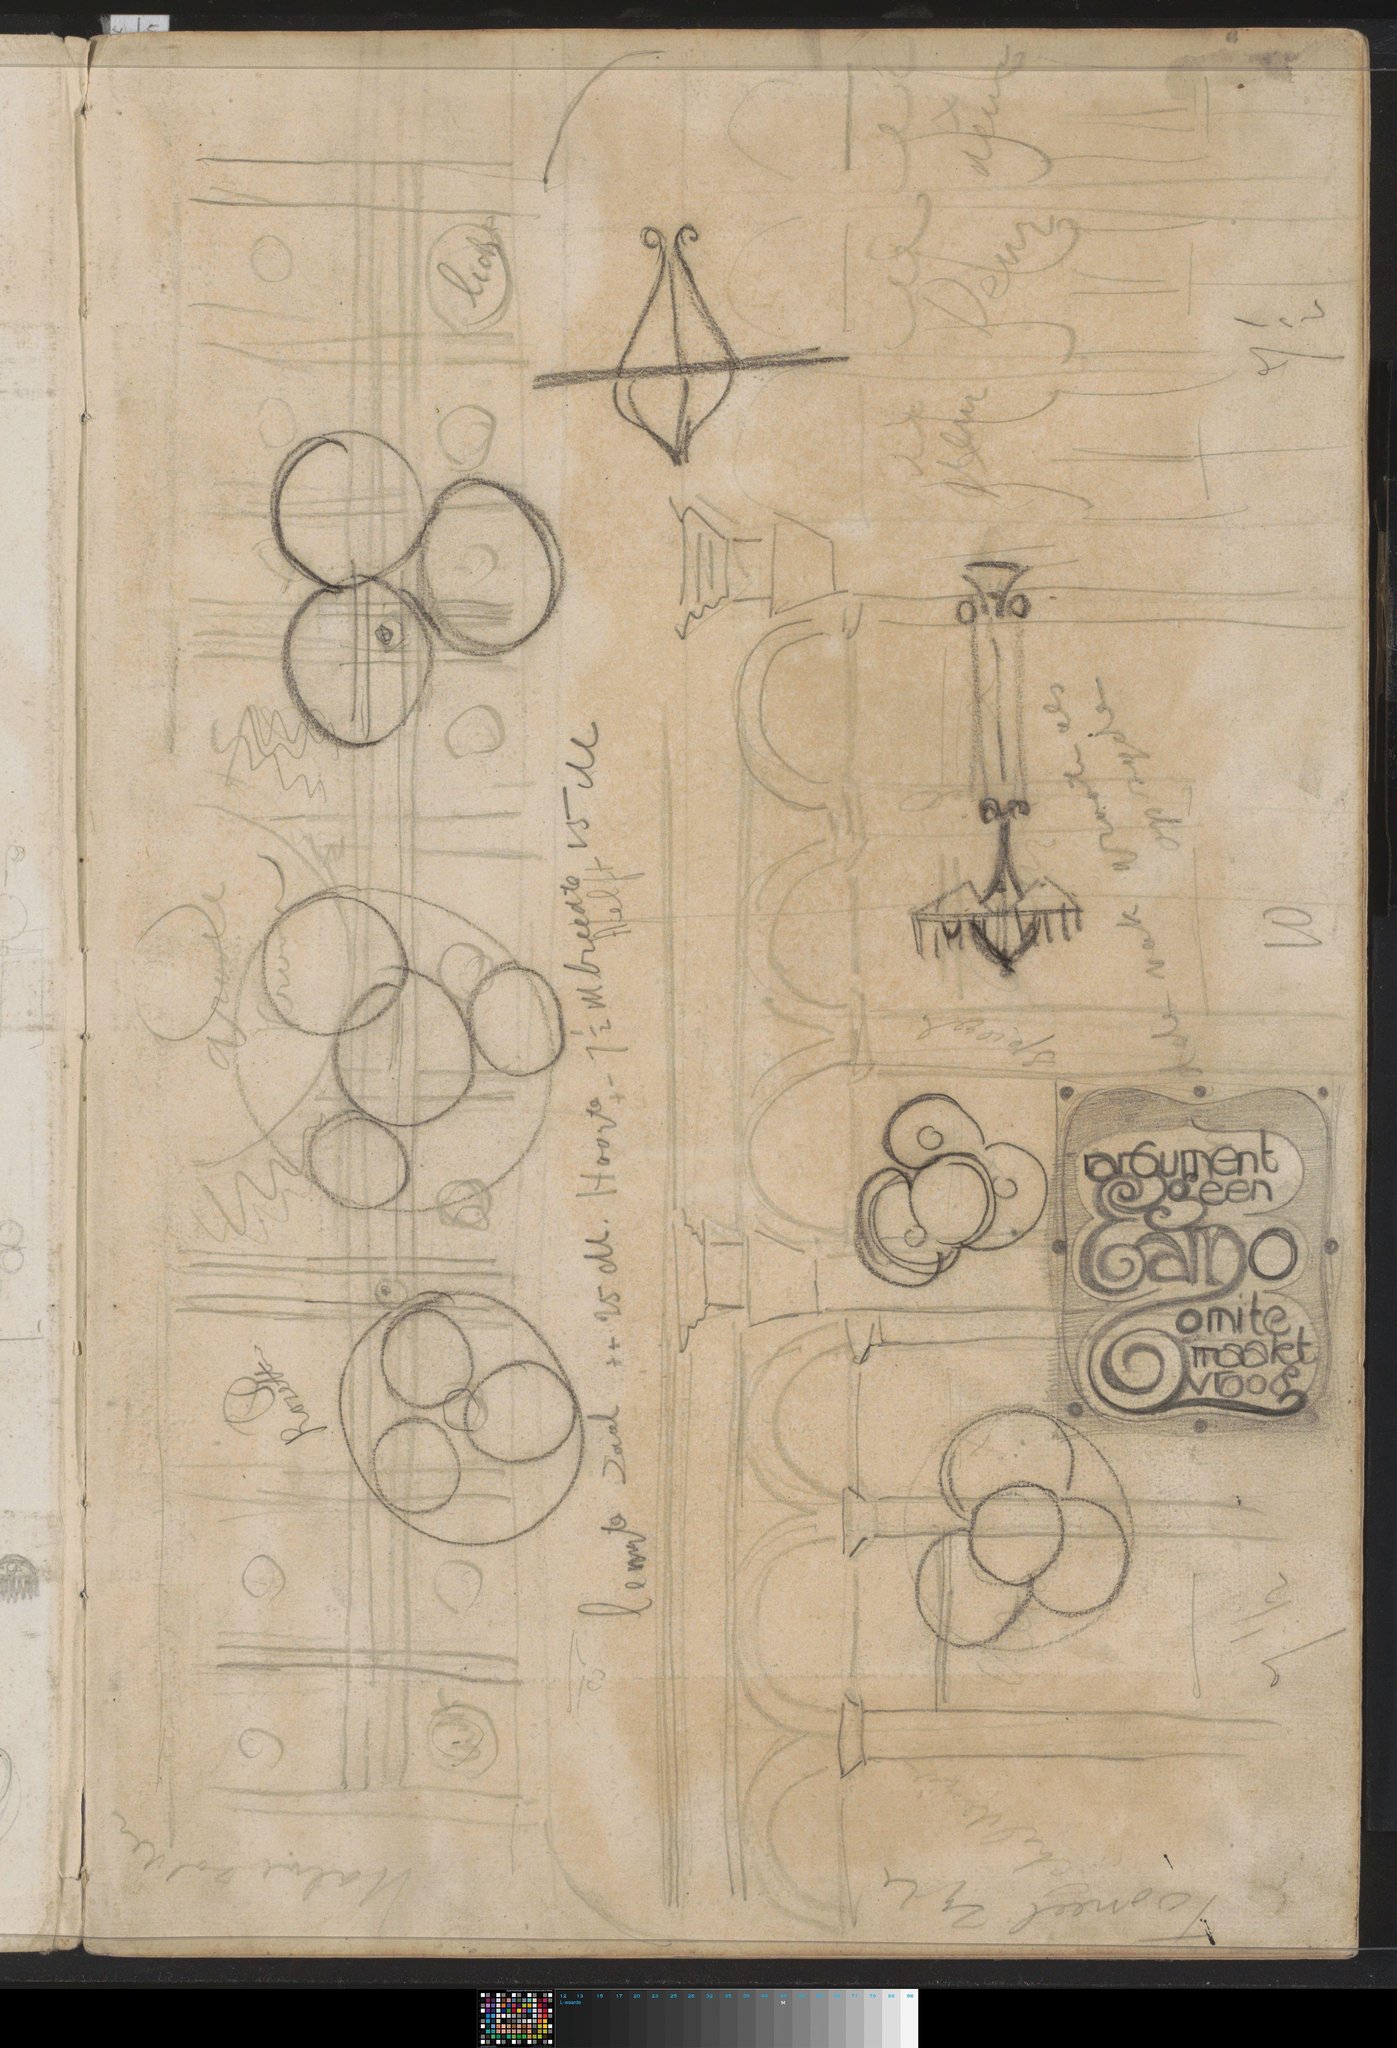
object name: sketchbook leaf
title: Rozetten en een kandelaar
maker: carel adolph lion cachet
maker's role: draughtsman, print maker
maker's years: 1864-1945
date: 1903-1904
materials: chalk, paper, pencil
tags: rosette ~ ornament, chandelier, candelabrum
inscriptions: annotation: ‘Tooneel [...] halve [...] Rozetten/ lengte zaal ++ 25 dl Hoogte +- 7 1/2 M breedte/ Helft 15 [...]/ spiegel/ [...] vak [...] als/ op zijde/ deur deur deur/ Argument/ Geen/ [...]alno/ Comite/ maakt/ vr[...]’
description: Tevens een ontwerp voor een bord met tekst. Blad 1 recto uit een schetsboek met 17 bladen.